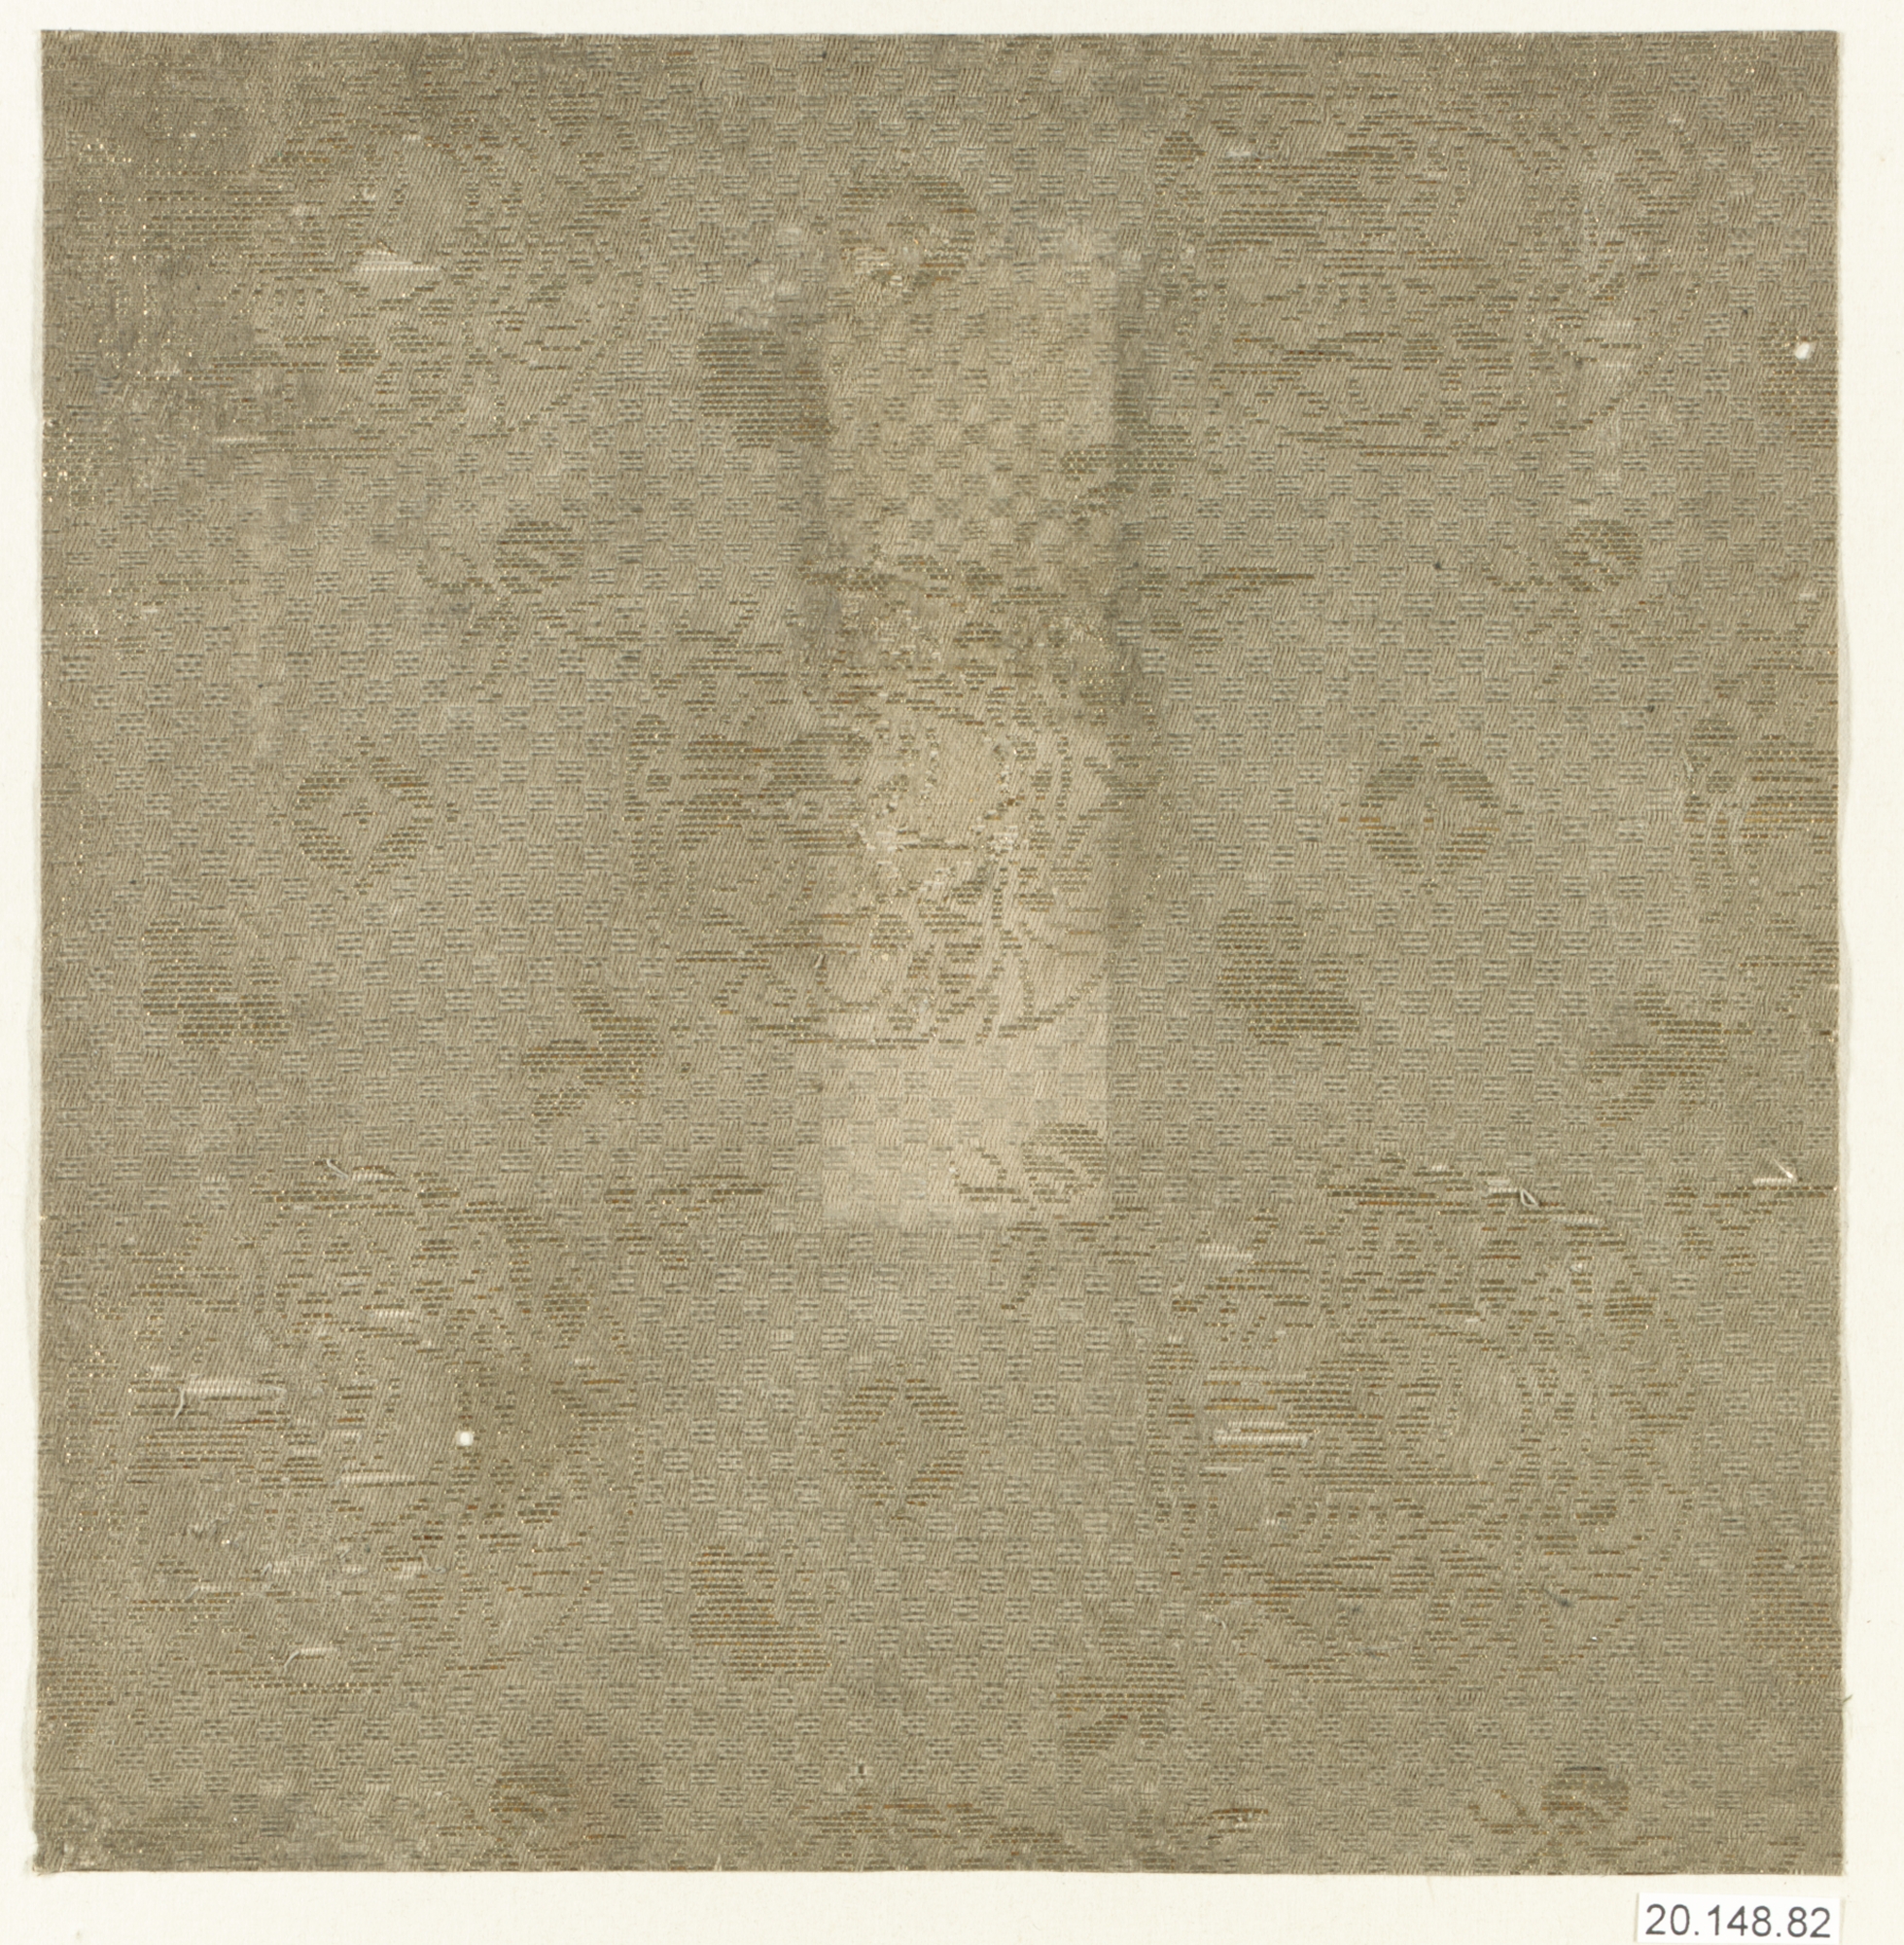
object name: piece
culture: japanese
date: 1601-1700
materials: silk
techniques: compound weave